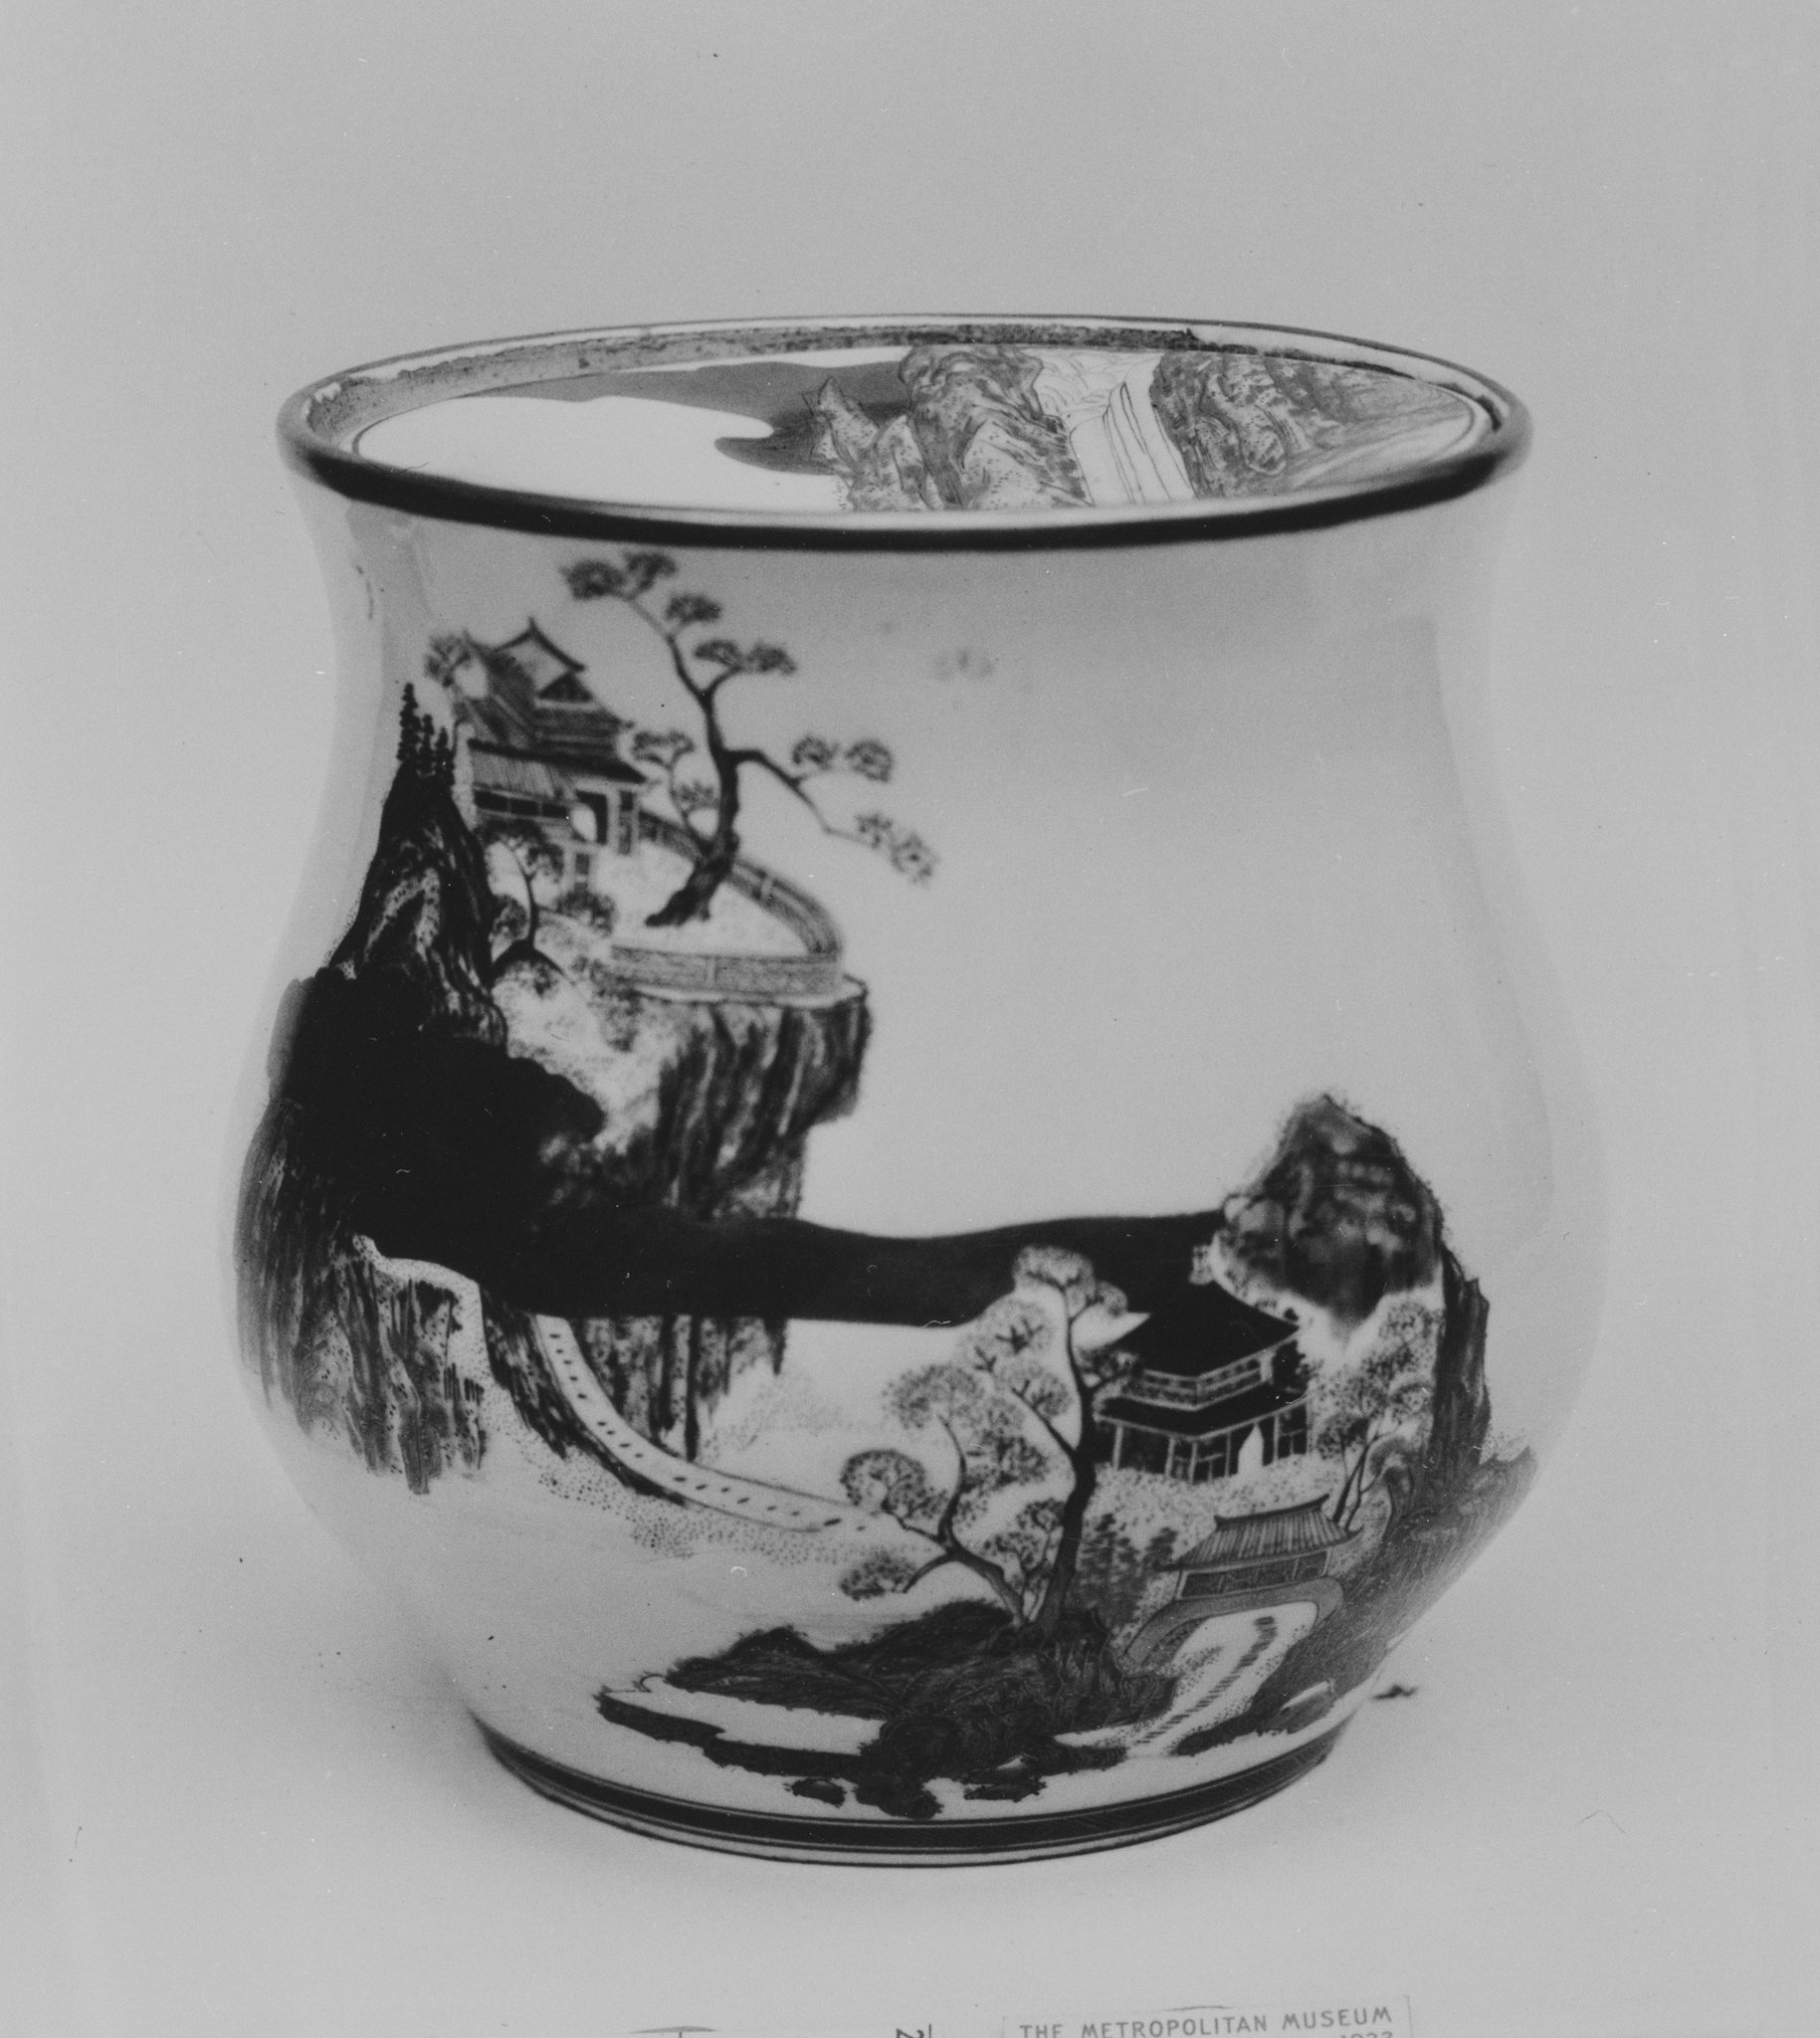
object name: water pot and cover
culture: japanese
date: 1830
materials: enamel, porcelain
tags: buildings,trees